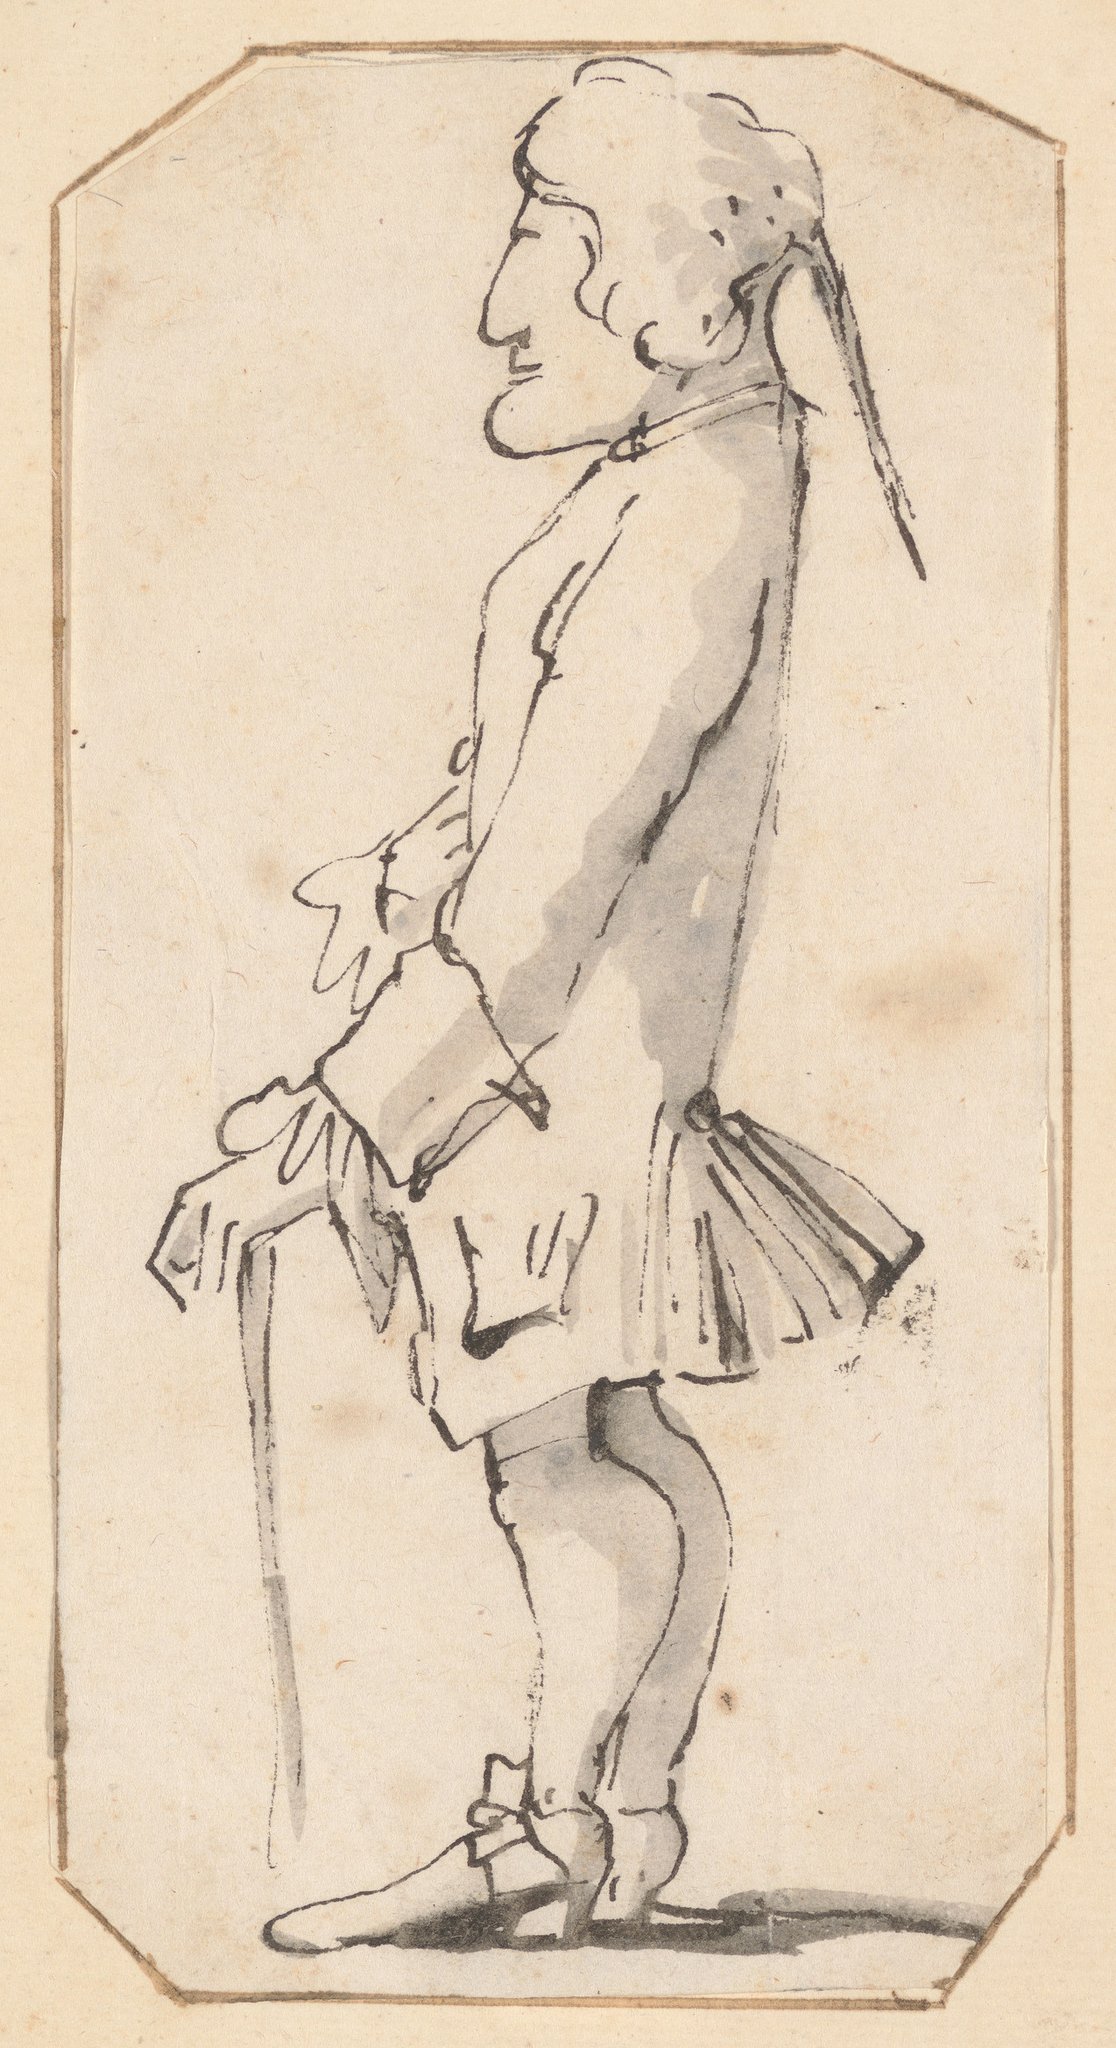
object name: drawing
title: Caricature of a Man Carrying a Stick, Standing in Profile to the Left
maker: giovanni battista tiepolo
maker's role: artist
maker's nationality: italian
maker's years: 1696-1770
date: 1760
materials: ink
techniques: pen, wash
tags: men,profiles